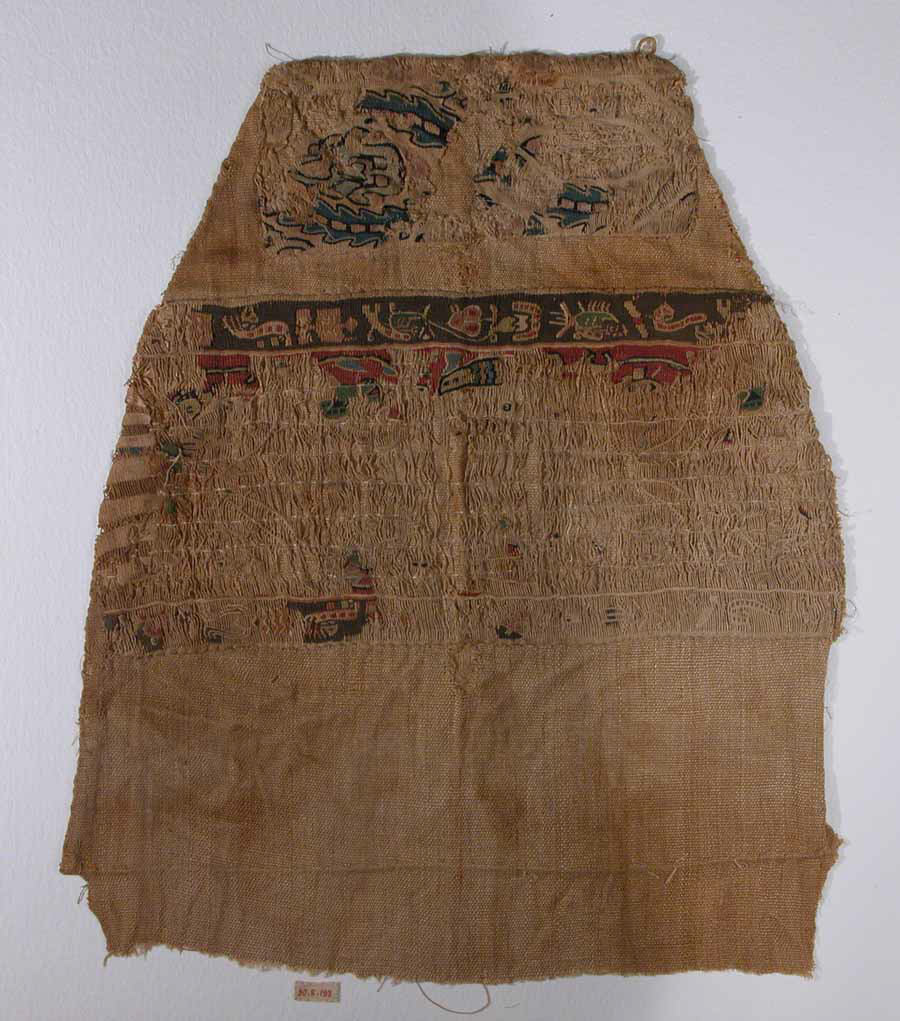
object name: textile fragment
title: Fragment of a Tunic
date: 501-600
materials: linen, wool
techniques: weave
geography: egypt